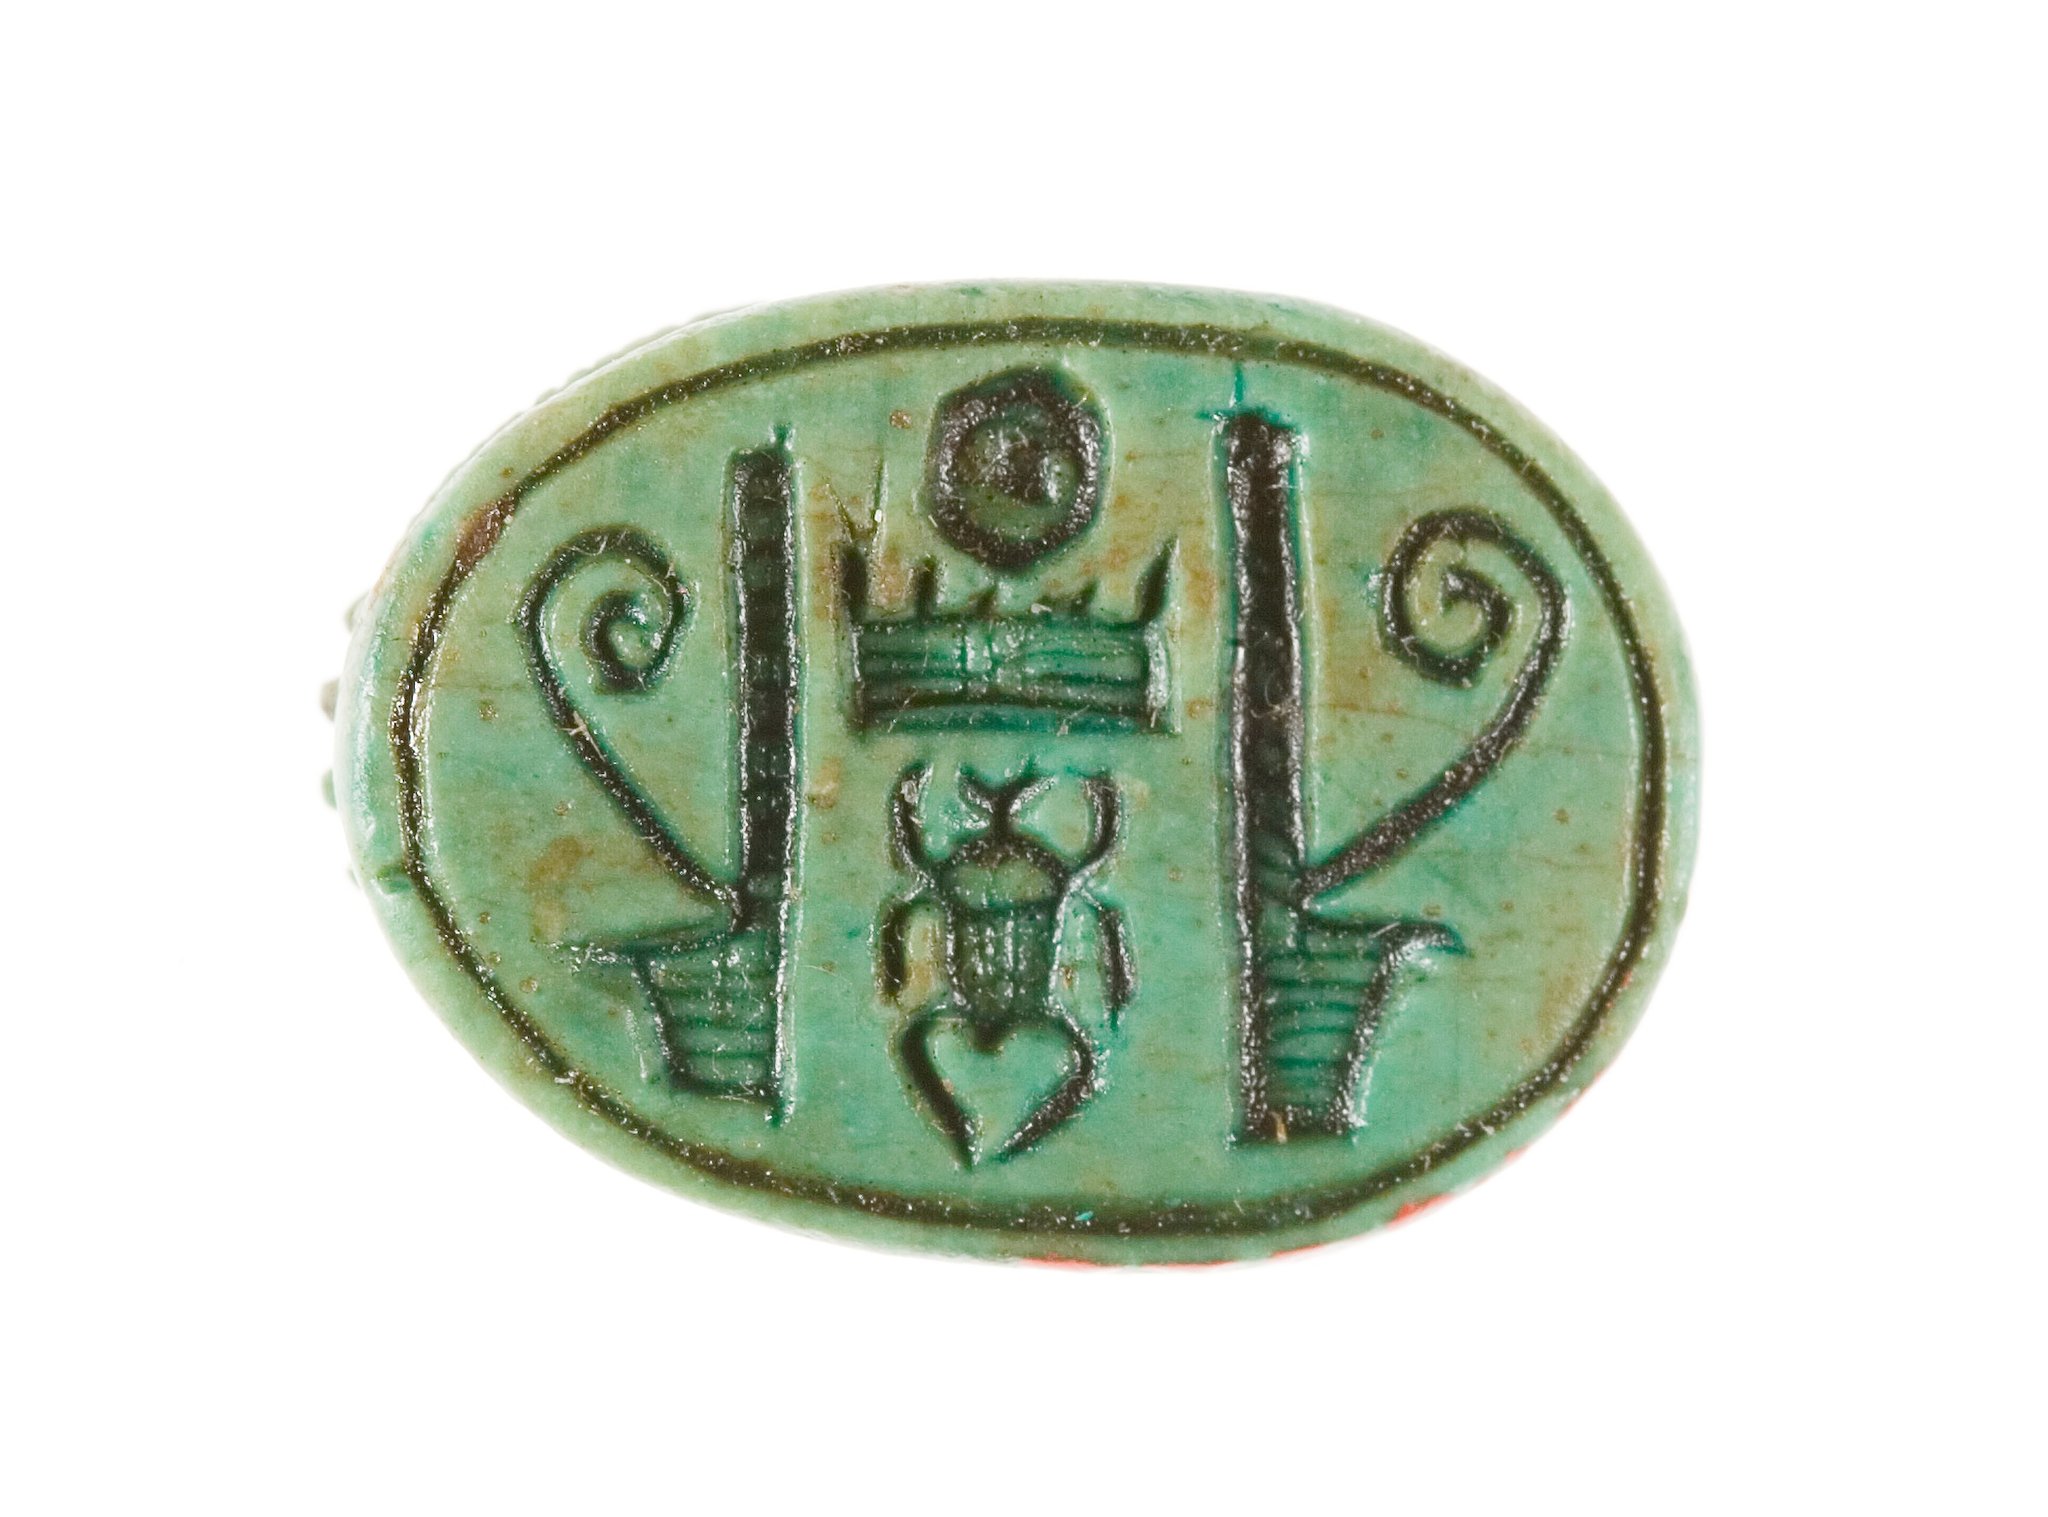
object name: scarab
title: Scarab Inscribed with the Throne Name of Thutmose III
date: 1479-1458 BCE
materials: stone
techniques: glazing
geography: egypt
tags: hieroglyphs,scarabs